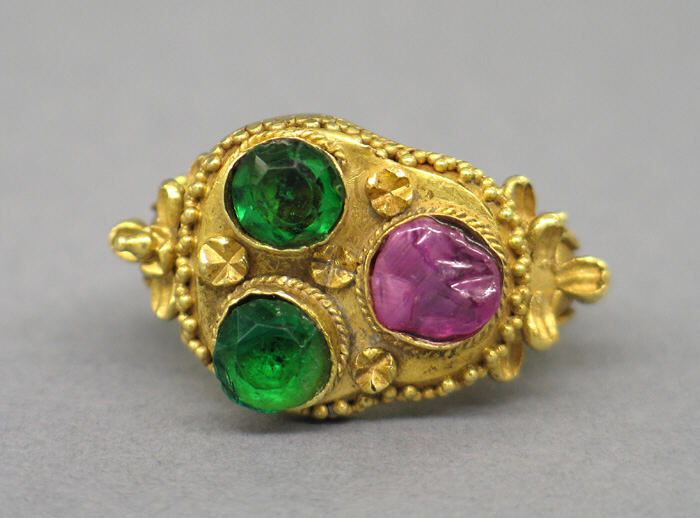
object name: ring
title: Ring with Bezel of Three Stones and Foliate Designs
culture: indonesian, javanese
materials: gold, stone